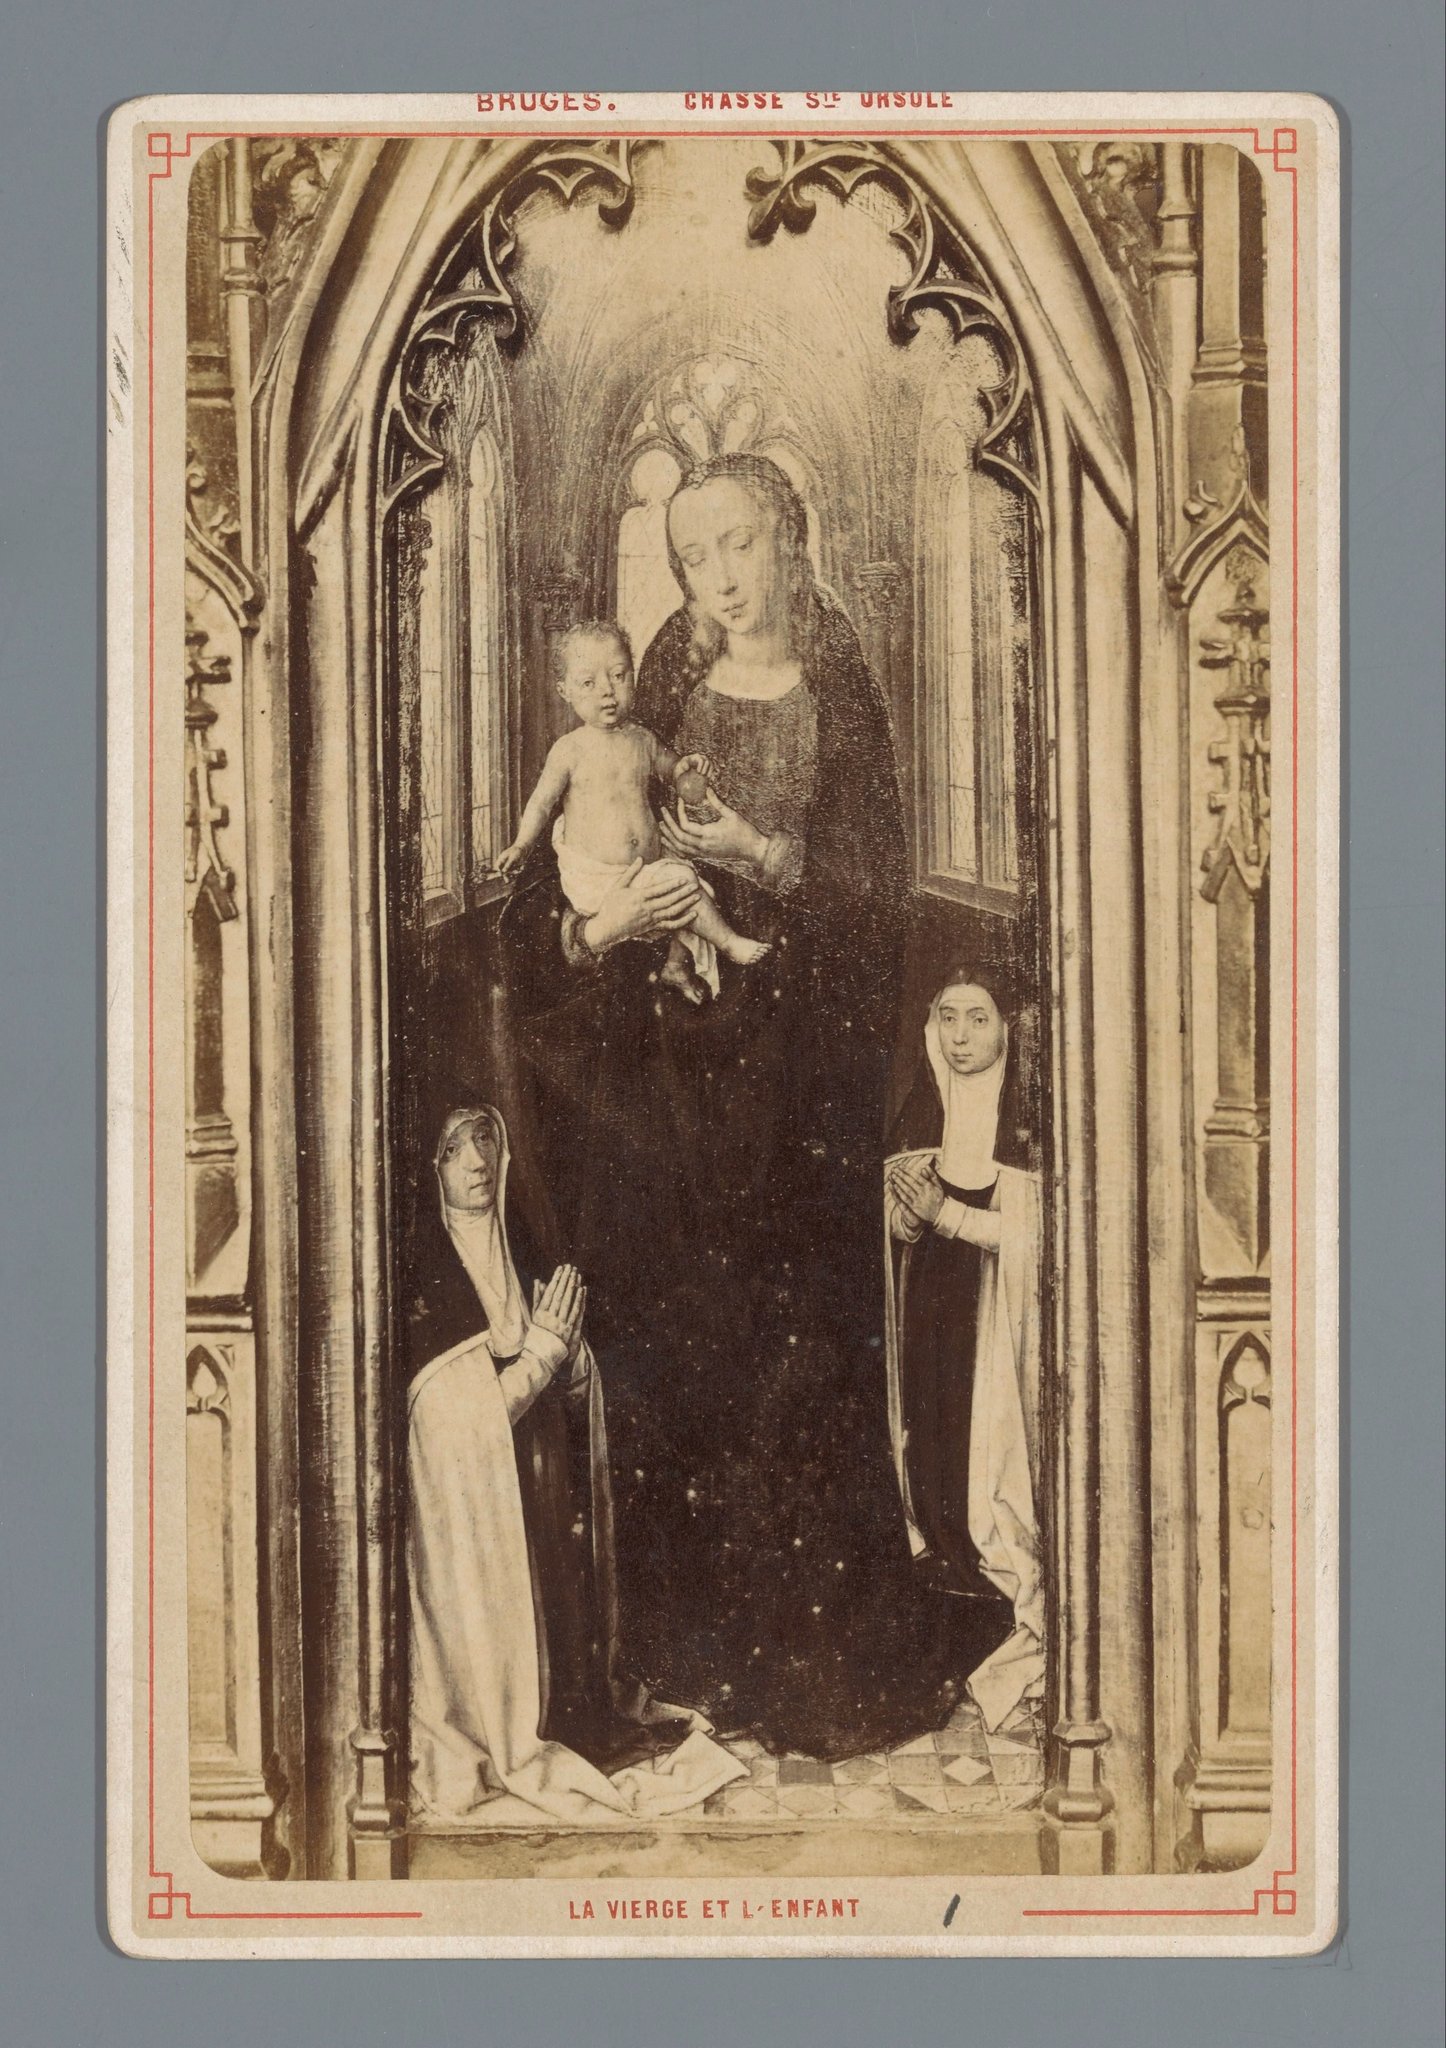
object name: cabinet photograph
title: La Vierge et l'Enfant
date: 1864-1900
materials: cardboard, photographic support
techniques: albumen print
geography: sint-janshospitaal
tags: madonna (i.e. mary with the christ-child) accompanied or surrounded by others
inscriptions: number: ‘1’